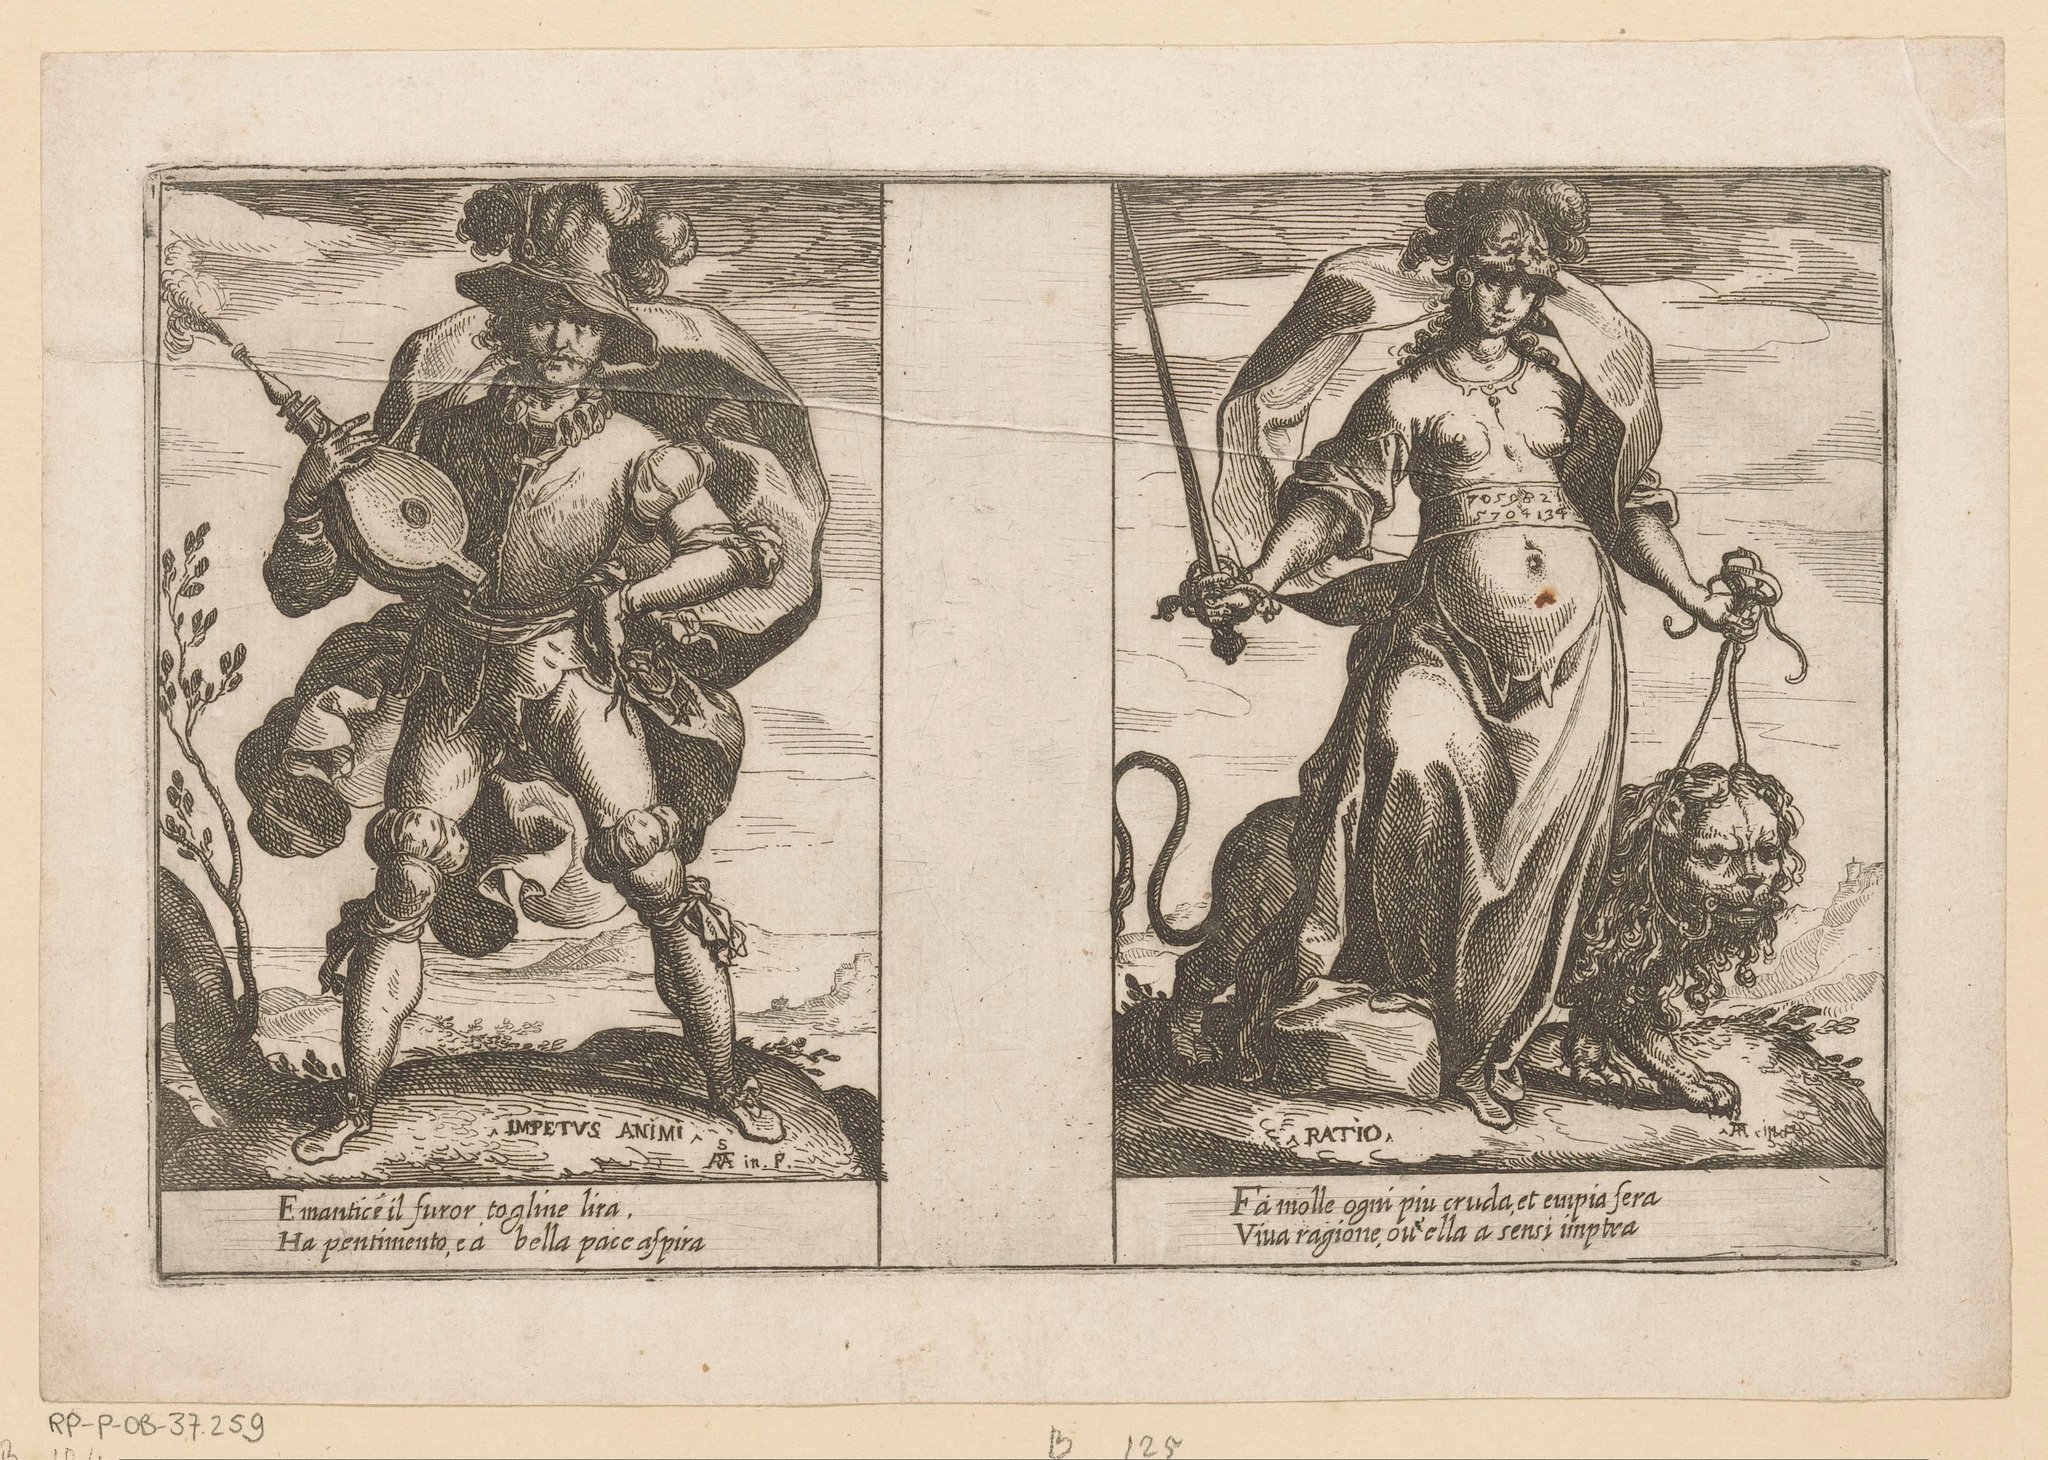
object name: print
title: Onstuimigheid en Rede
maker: raffaello schiaminossi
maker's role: painter, print maker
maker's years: 1572-1622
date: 1605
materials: paper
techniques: etching, intaglio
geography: italy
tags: rationality, reasoning; 'ratiocinatione o discorso' (ripa), beasts of prey, predatory animals: lion, bellows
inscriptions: collector's mark: Lugt 240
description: Twee voorstellingen van personificaties. Links: Onstuimigheid (Impetus Animi) als man met gevederde hoed en een blaasbalg. Rechts: Rede (Ratio) als vrouw met zwaard en een leeuw. Beide voorstellingen met twee Italiaanse versregels in de ondermarge.